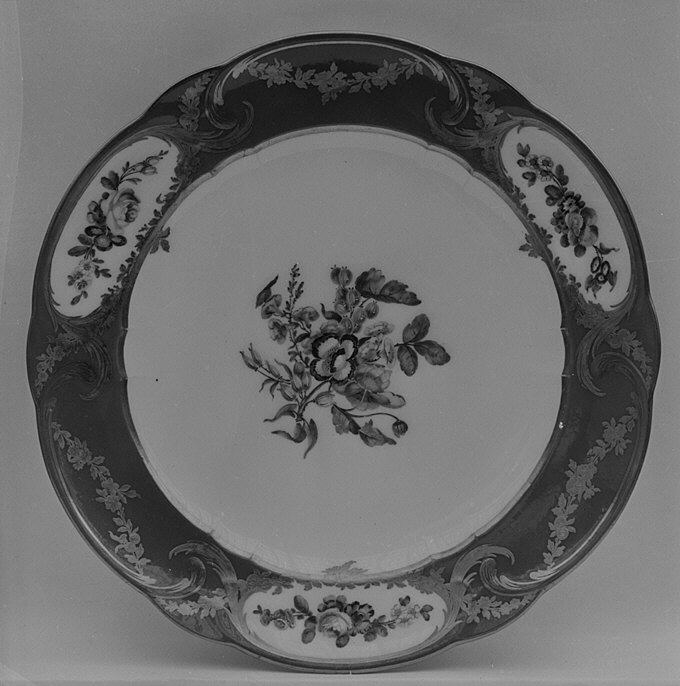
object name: plate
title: Plate (assiette à palmes) (1 of 102) (part of a service)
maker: sèvres manufactory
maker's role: manufactory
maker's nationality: french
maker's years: 1740-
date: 1772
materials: soft paste porcelain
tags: flowers